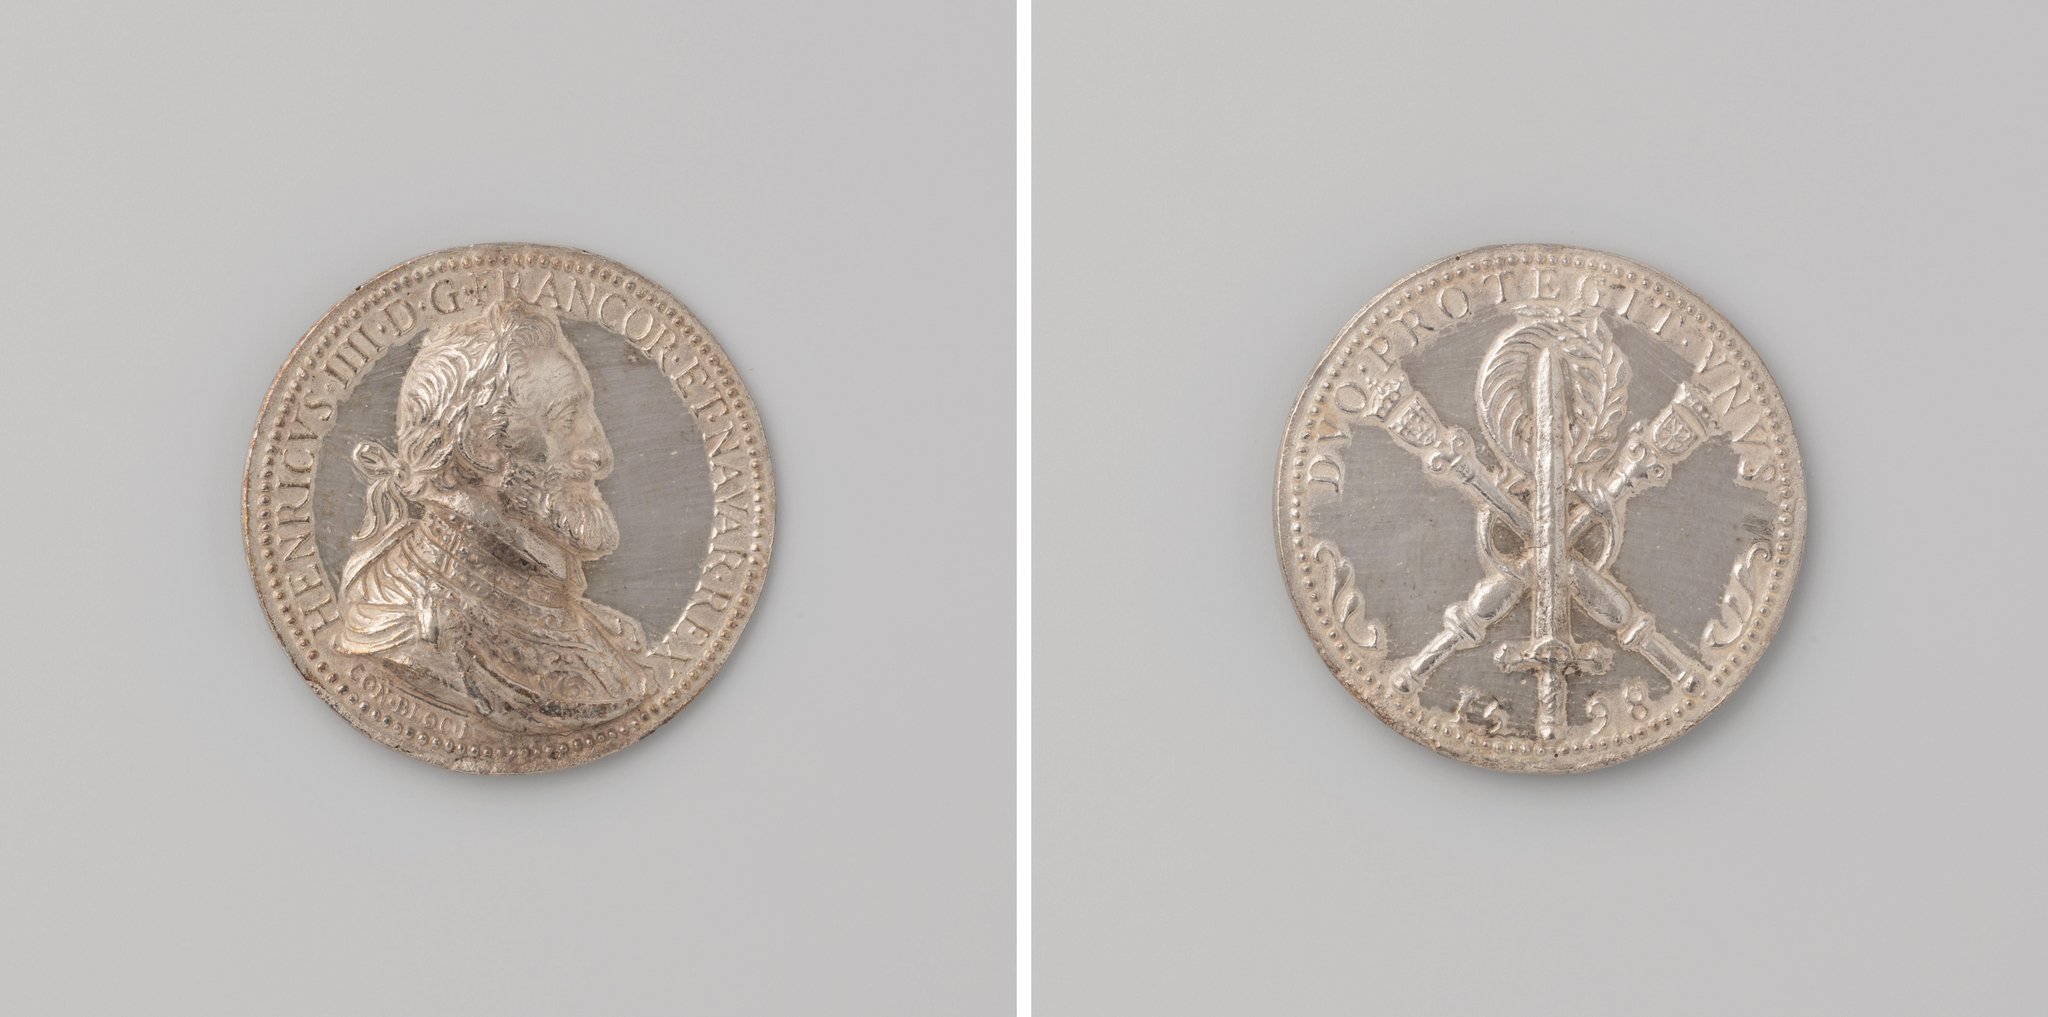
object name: medal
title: Hendrik IV, koning van Frankrijk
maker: coenraad bloc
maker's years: 1545-1602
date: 1598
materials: silver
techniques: casting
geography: flanders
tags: hendrik iv (koning van frankrijk en navarra)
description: Zilveren penning. Voorzijde: borststuk man met lauwerkrans binnen omschrift. Keerzijde: zwaard en twee scepters gekruist en met zegetakken omwonden binnen omschrift